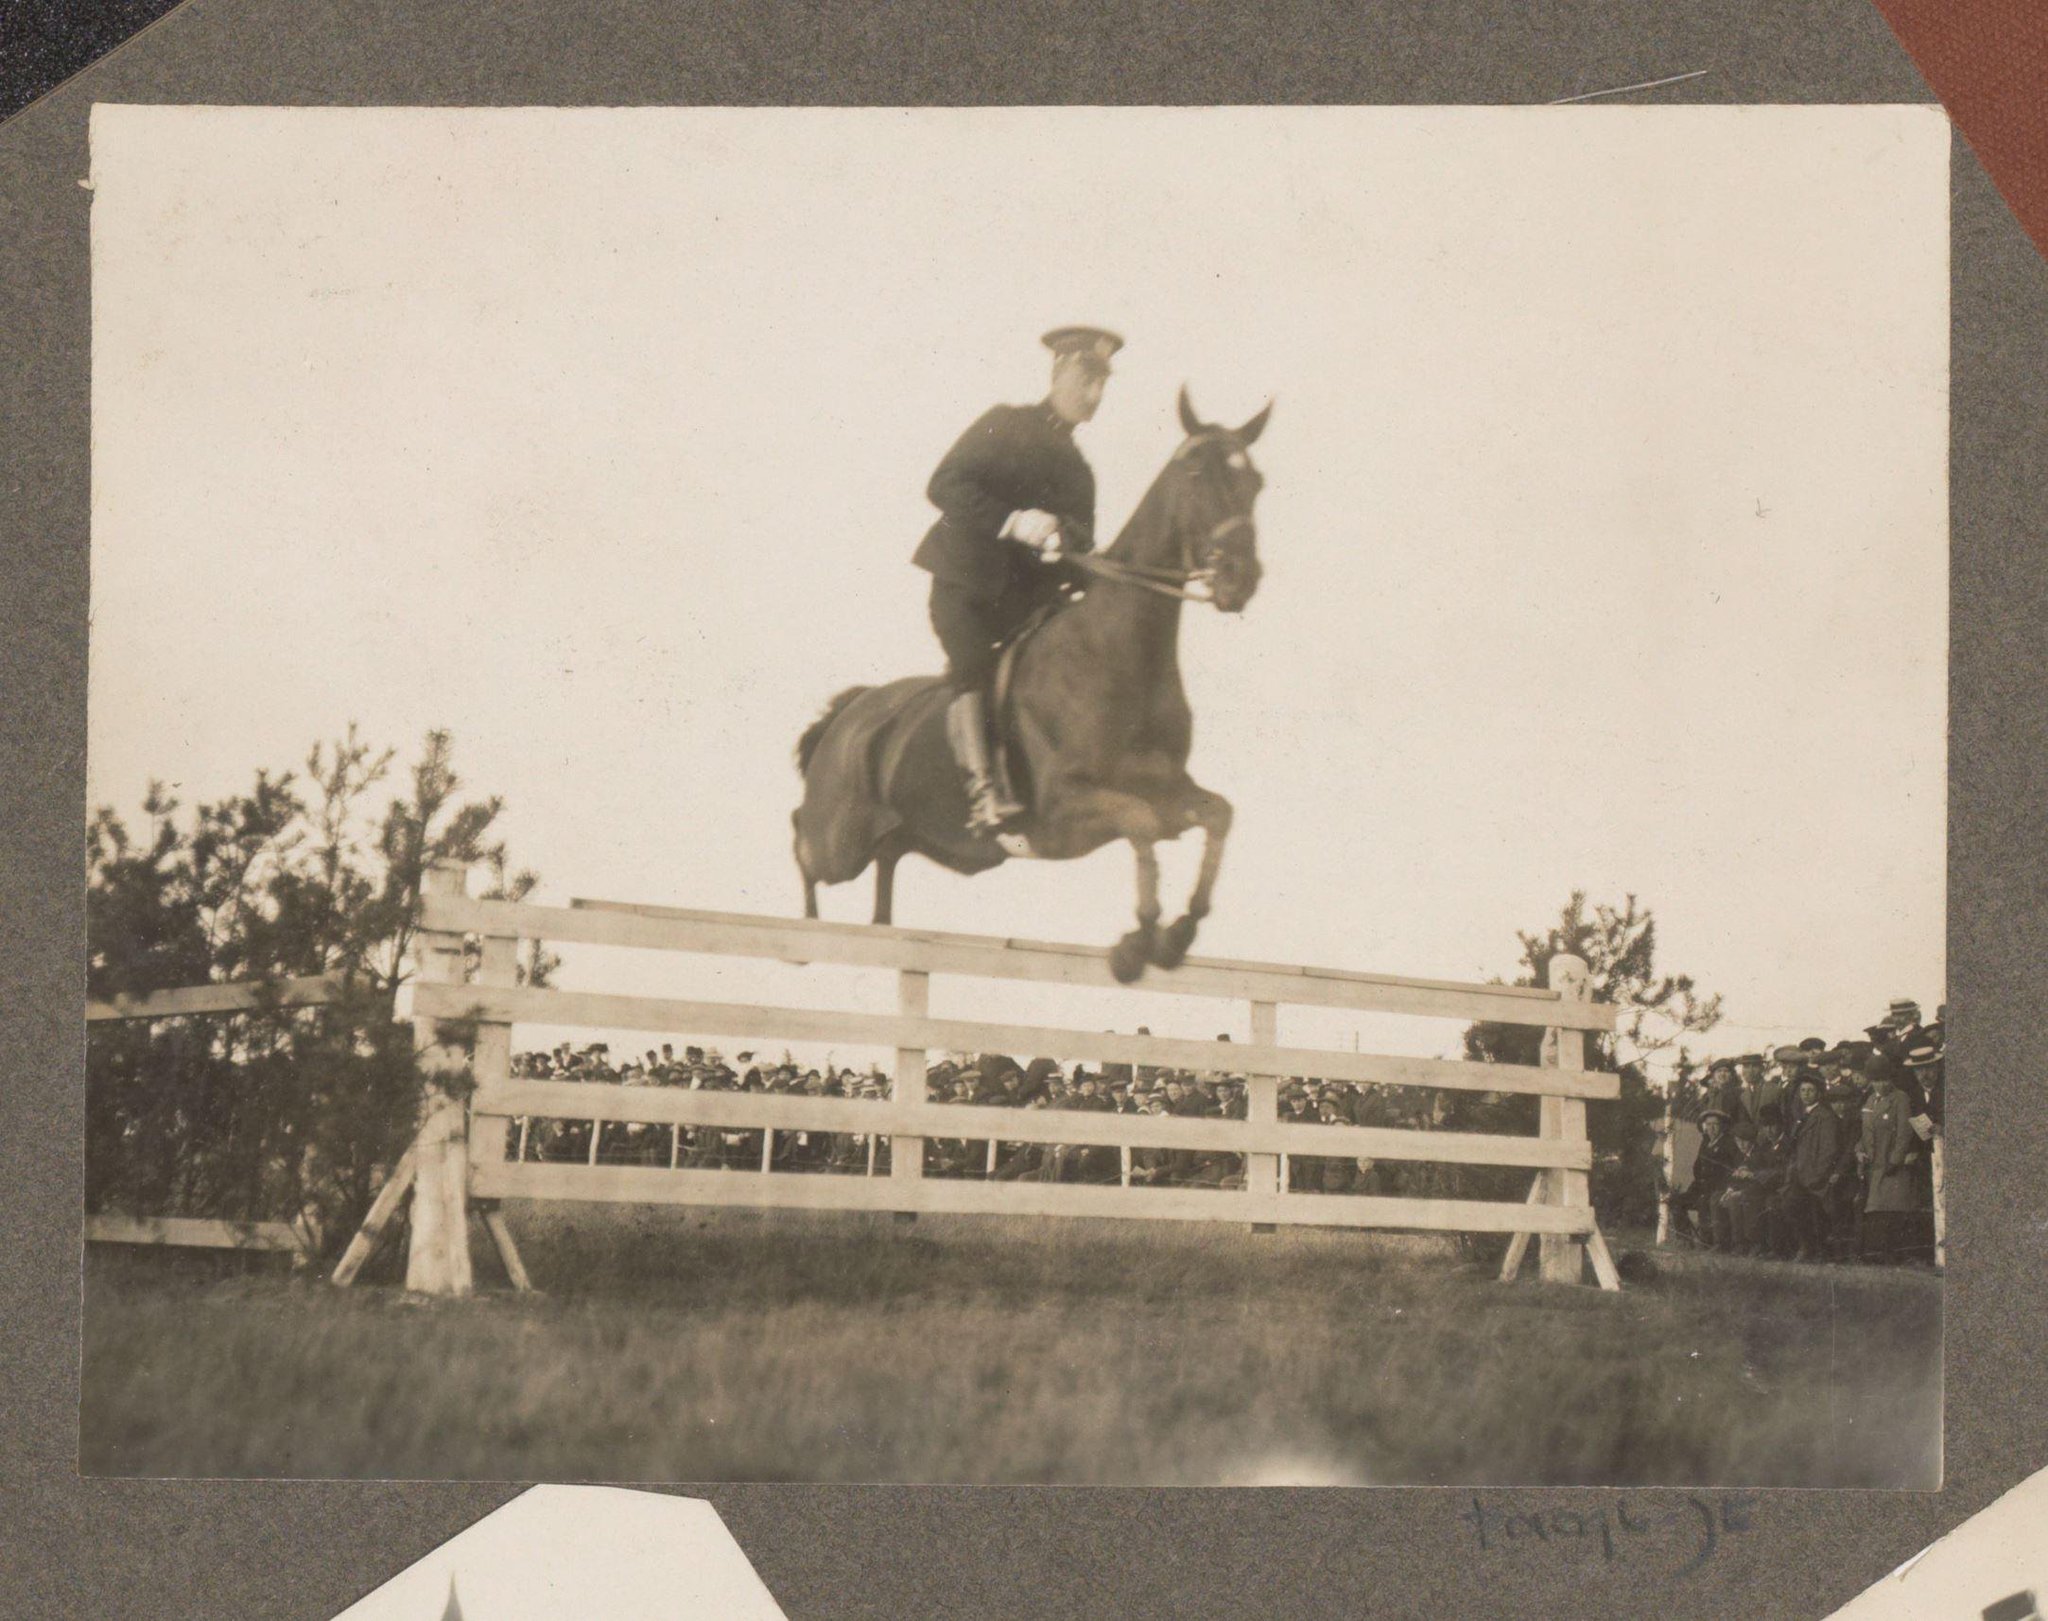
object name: photograph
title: Ruitertafereel op Koninklijke Houtvesterij Het Loo: geüniformeerde ruiter neemt hindernis op een renbaan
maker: Anonymous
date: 1900-1925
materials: photographic support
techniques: gelatin silver print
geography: het loo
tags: riding a horse, ass, or mule; rider, horseman, crowd, mob, hunting, chase, hunting-ground, horse-racing, jumping (horse in motion), (military) uniforms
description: Onderdeel van Fotoalbum van de heer Brams, opperhoutvester van koningin Wilhelmina op Koninklijke Houtvesterij Het Loo.